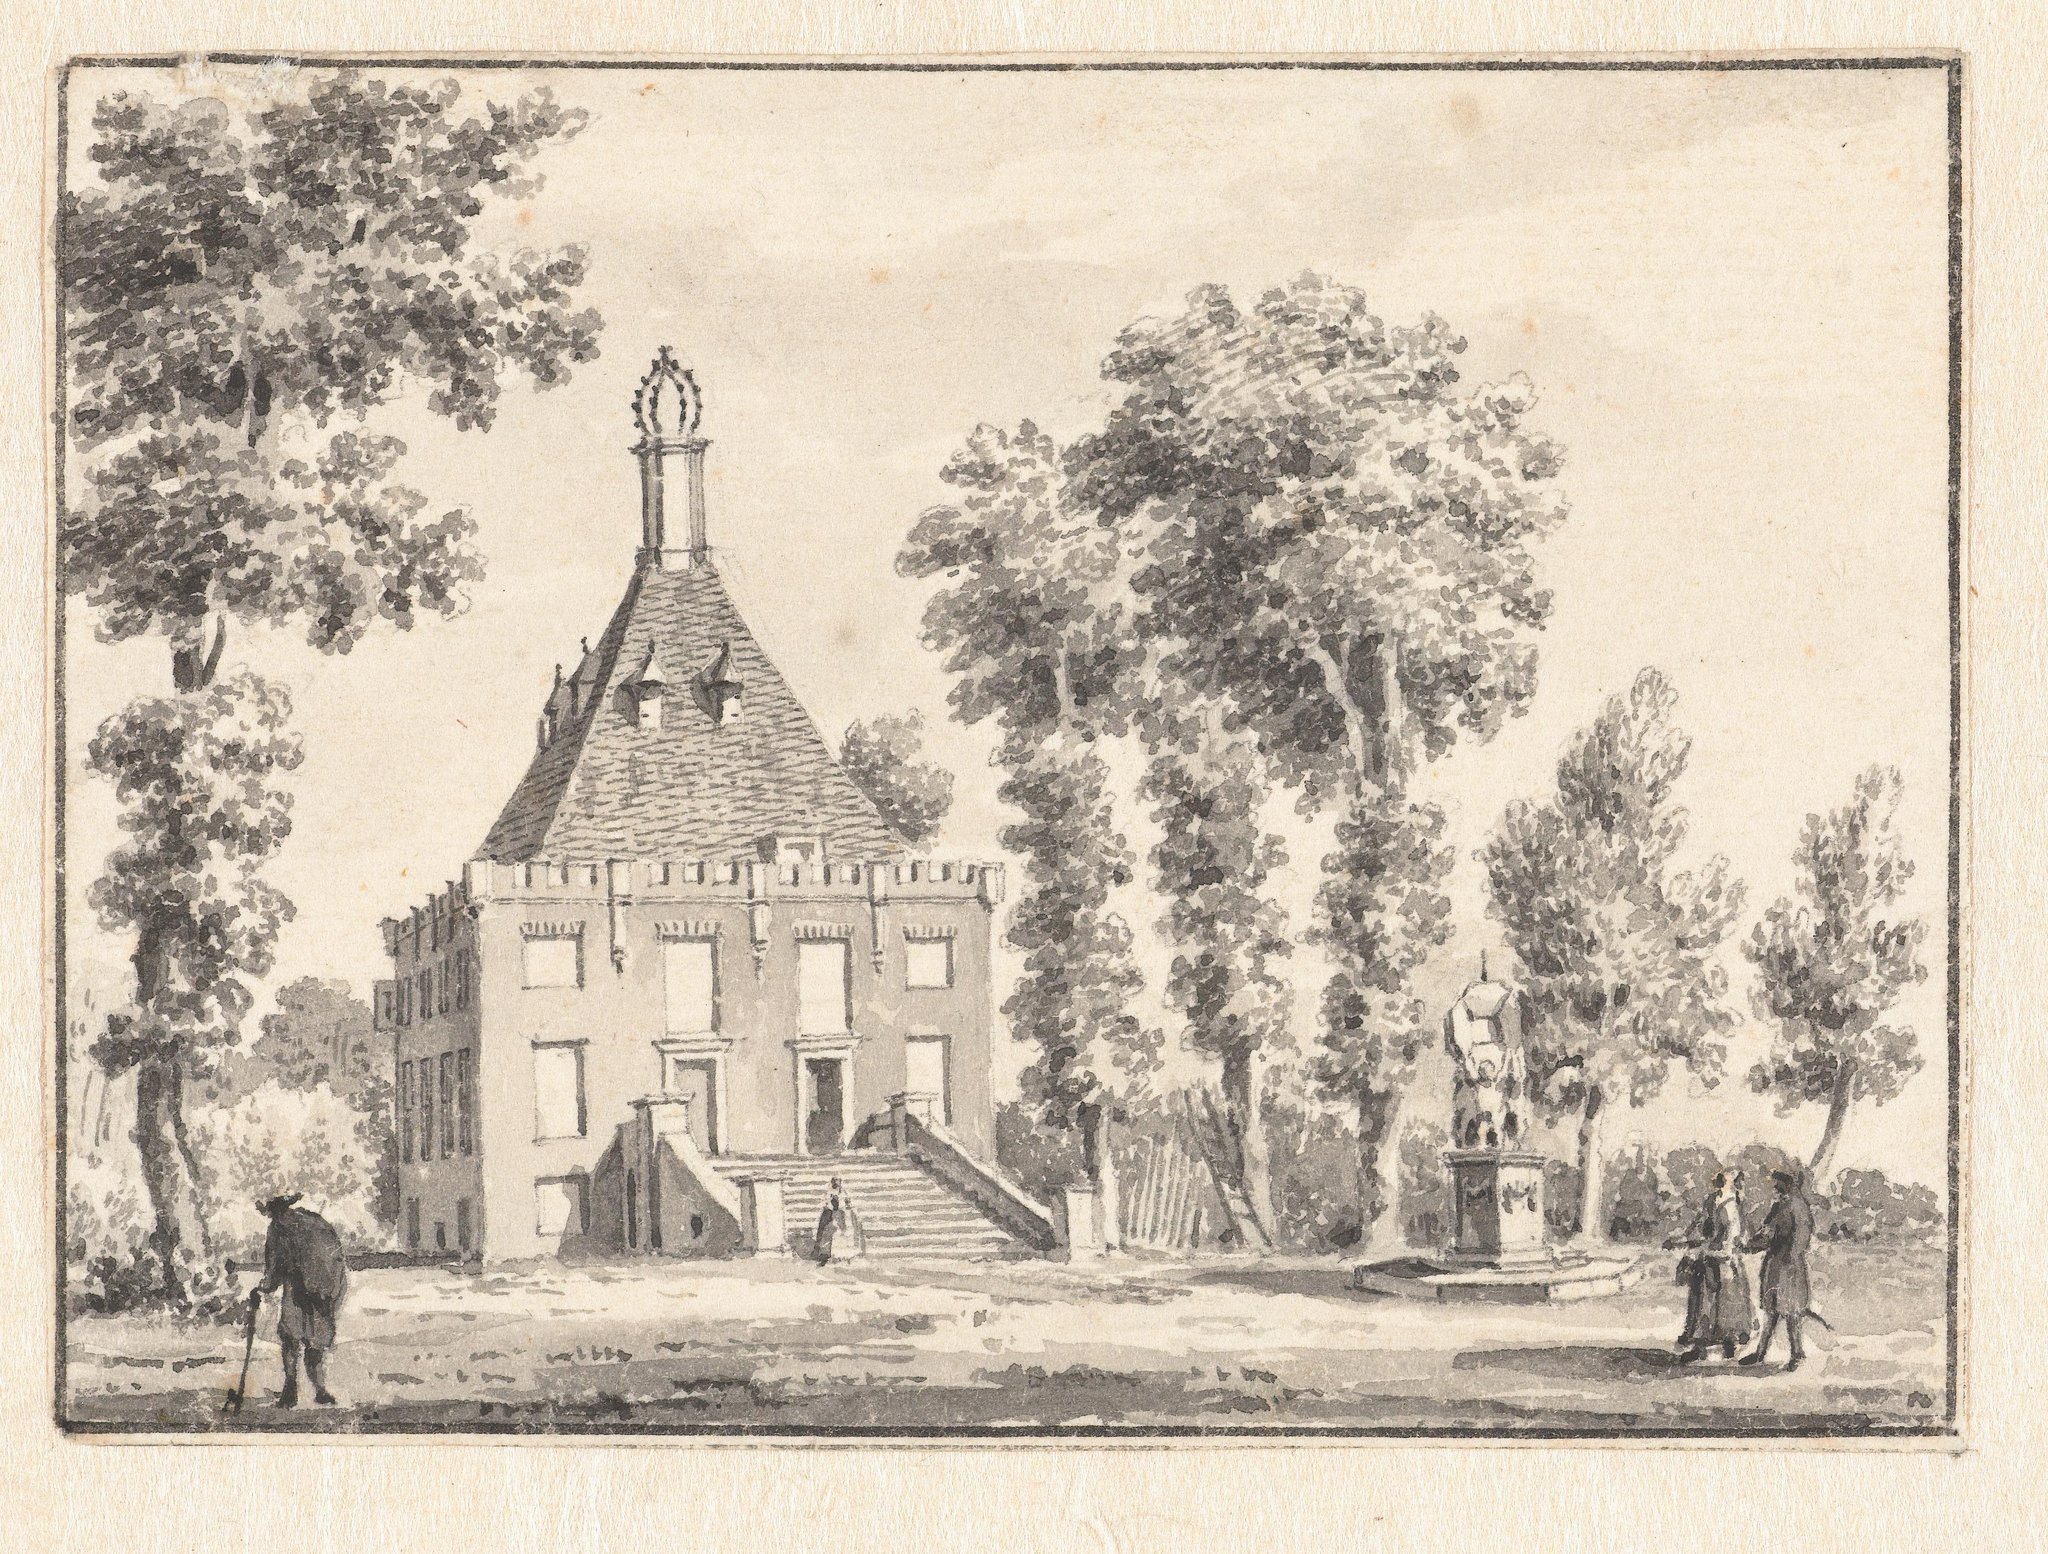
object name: drawing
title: Het huis Ameliastein of Amaliestein bij Vianen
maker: hendrik spilman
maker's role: draughtsman, painter, print maker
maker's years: 1721-1784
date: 1733-1784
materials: ink, paper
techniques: brush, pen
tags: castle, rural housing, e.g. country-house, villa, cottage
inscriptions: inscription: ‘H. Spilman del. Ameliastein in 't Viaansche Bosch 1733 A.D.H.’